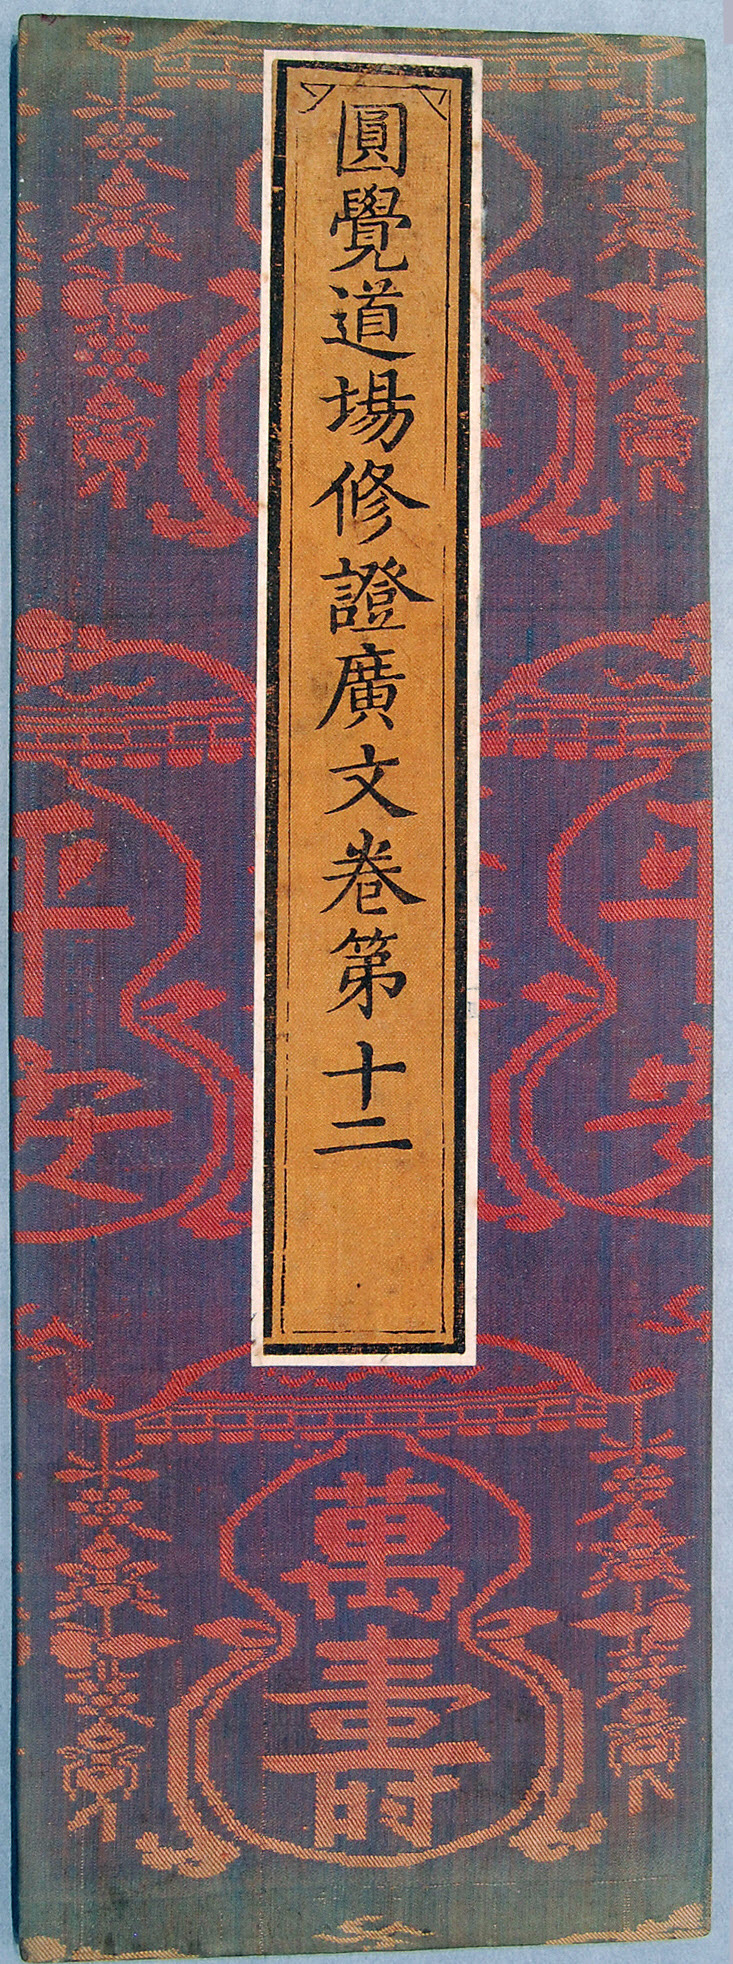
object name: sutra cover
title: Sutra Cover with Chinese Characters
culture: chinese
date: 1501-1600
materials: silk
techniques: patterning, weave